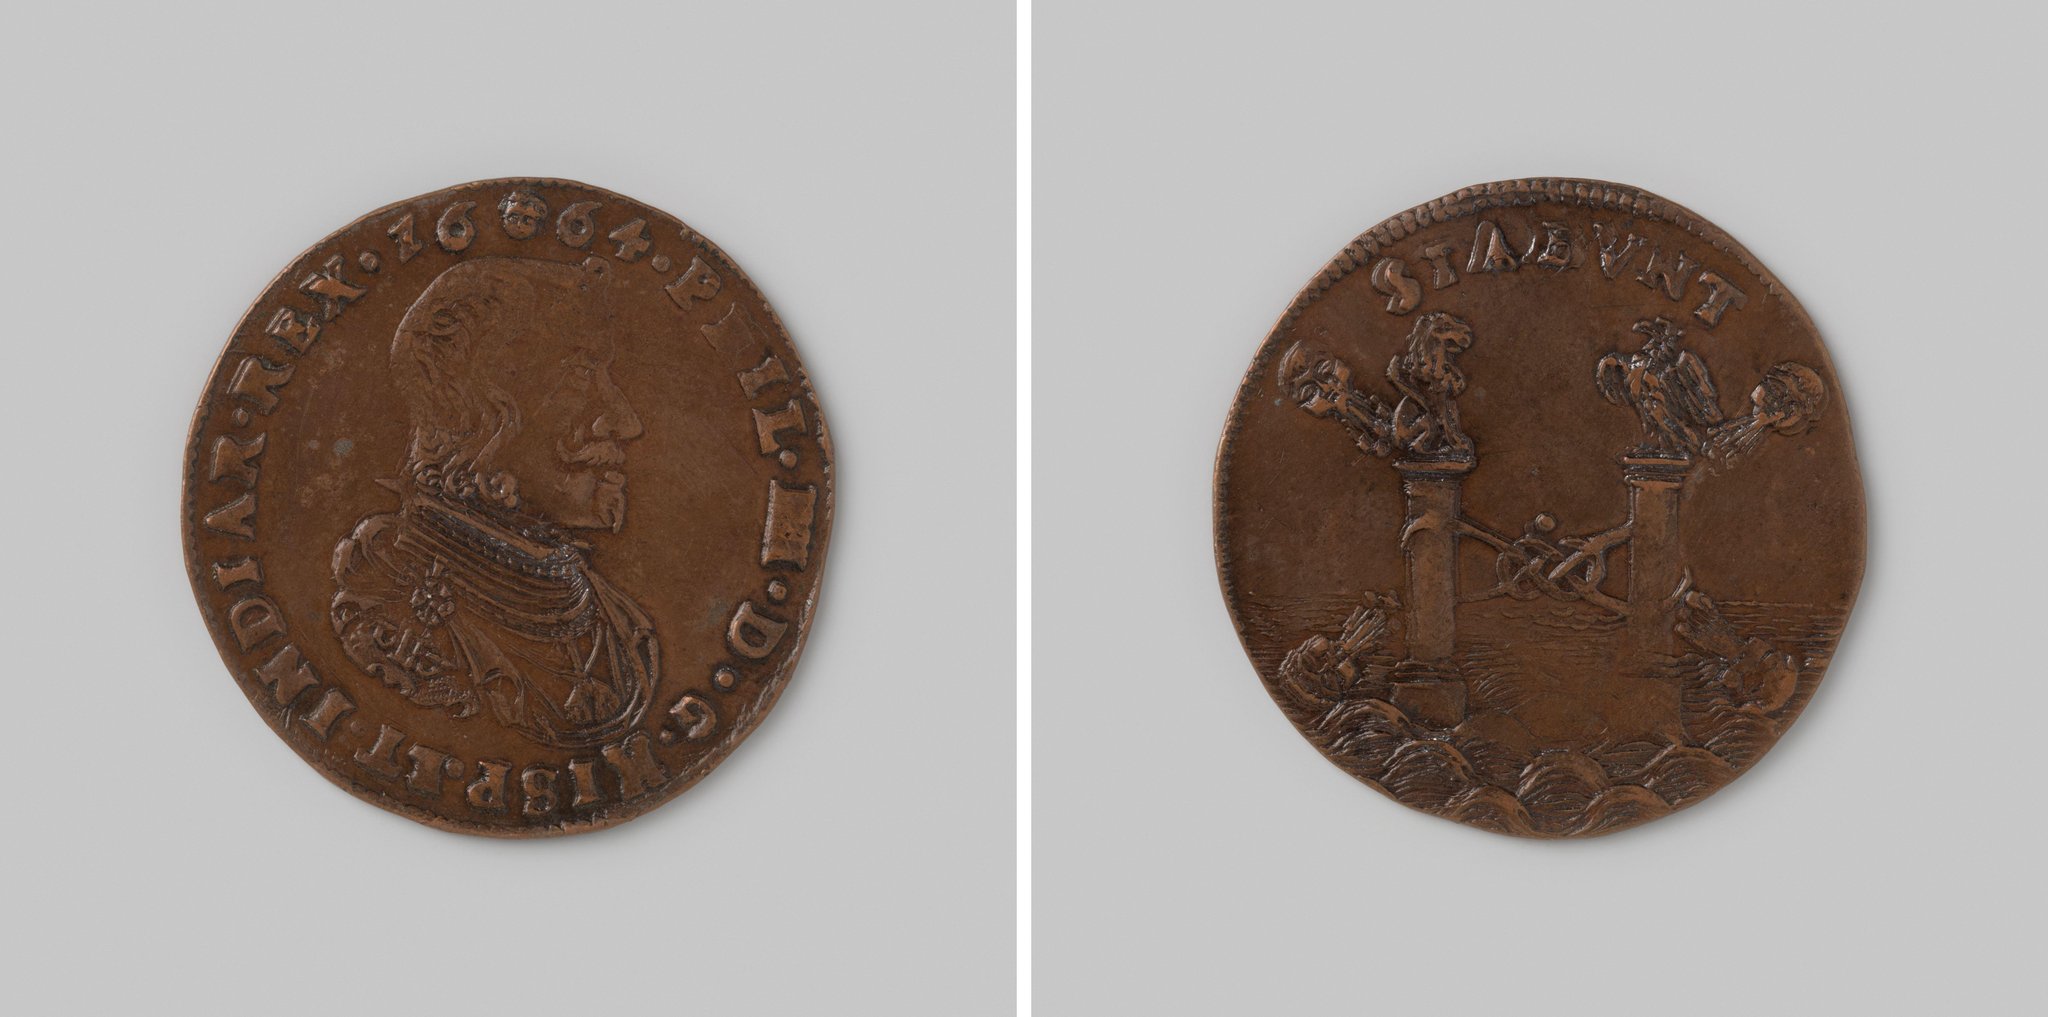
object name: history medal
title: Rekenpenning uit Brussel op het verbond tussen Spanje en Oostenrijk 1664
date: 1664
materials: copper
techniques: striking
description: Koperen penning, op de voorzijde het borstbeeld van Philips IV naar rechts met omschrift, op de keerzijde in zee twee zuilen, met leeuw en adelaar, verbonden door een koord, te midden van storm en golven, met bovenaan omschrift.